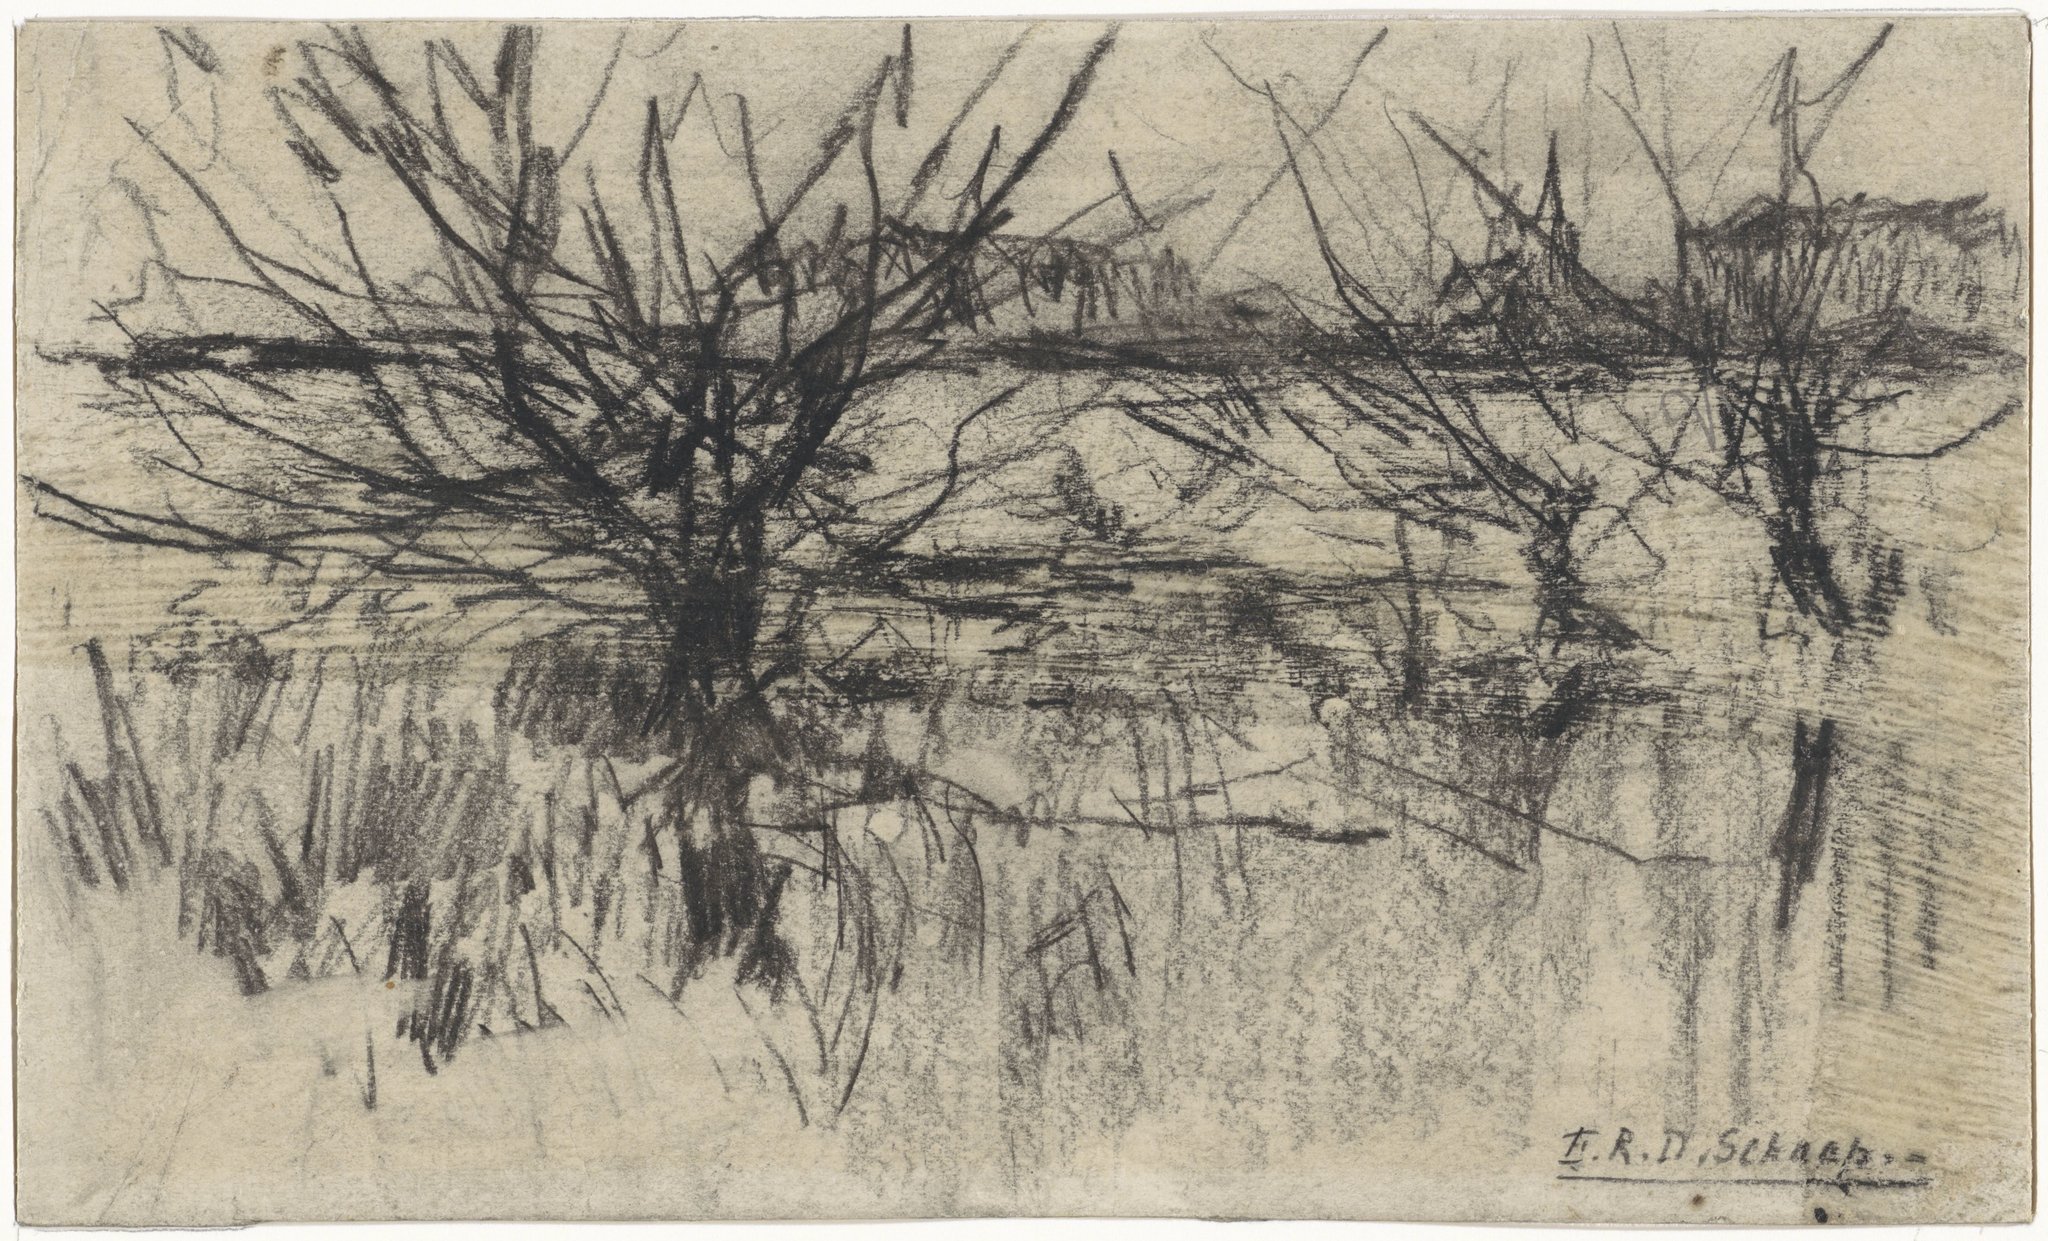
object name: drawing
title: Knotwilgen langs het water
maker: egbert rubertus derk schaap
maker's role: draughtsman, painter, print maker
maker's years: 1862-1939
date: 1872-1939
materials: cardboard, chalk